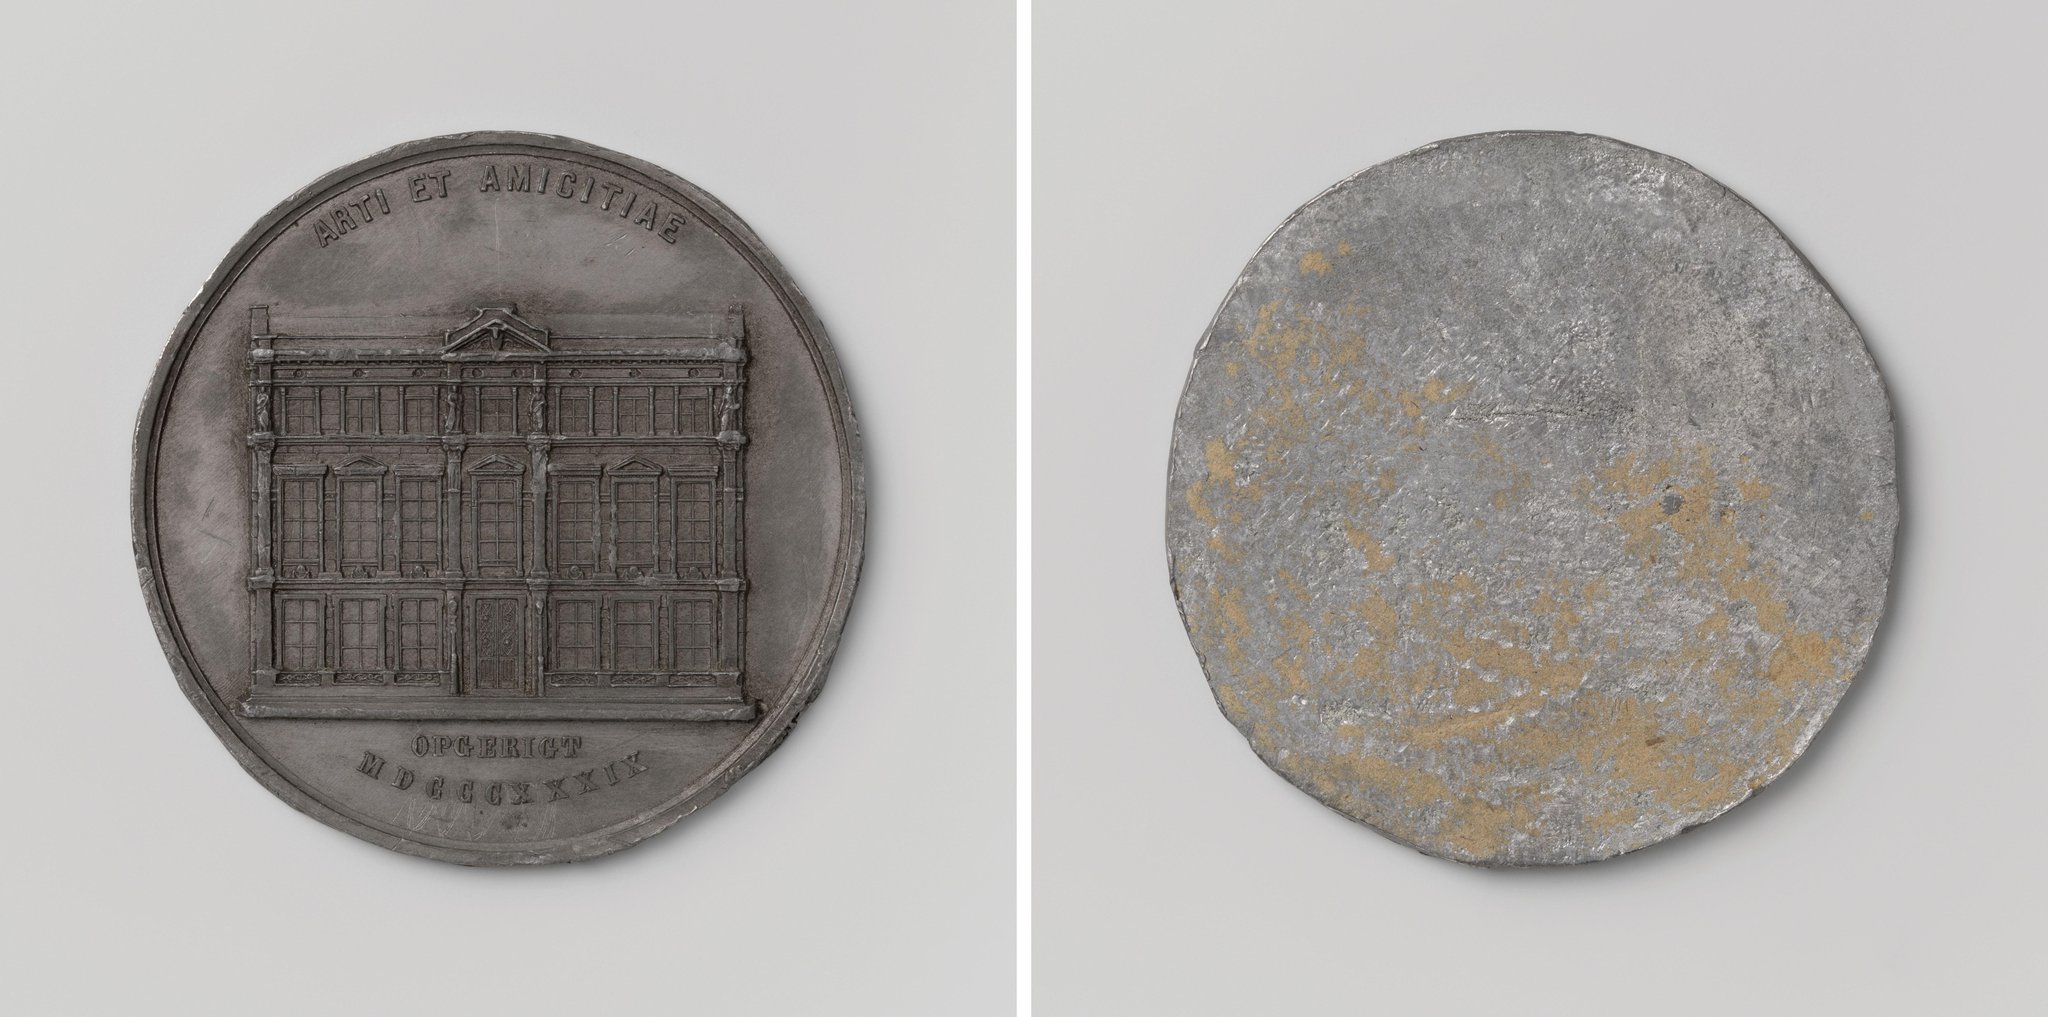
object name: history medal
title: Oprichting van de maatschappij Arti et Amicitiae te Amsterdam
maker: Anonymous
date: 1839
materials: lead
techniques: striking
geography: netherlands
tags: amsterdam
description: Eenzijdige loden penning. Voorzijde: gebouw van de nieuwe maatschappij binnen omschrift; afsnede: datering. Keerzijde: blanco.